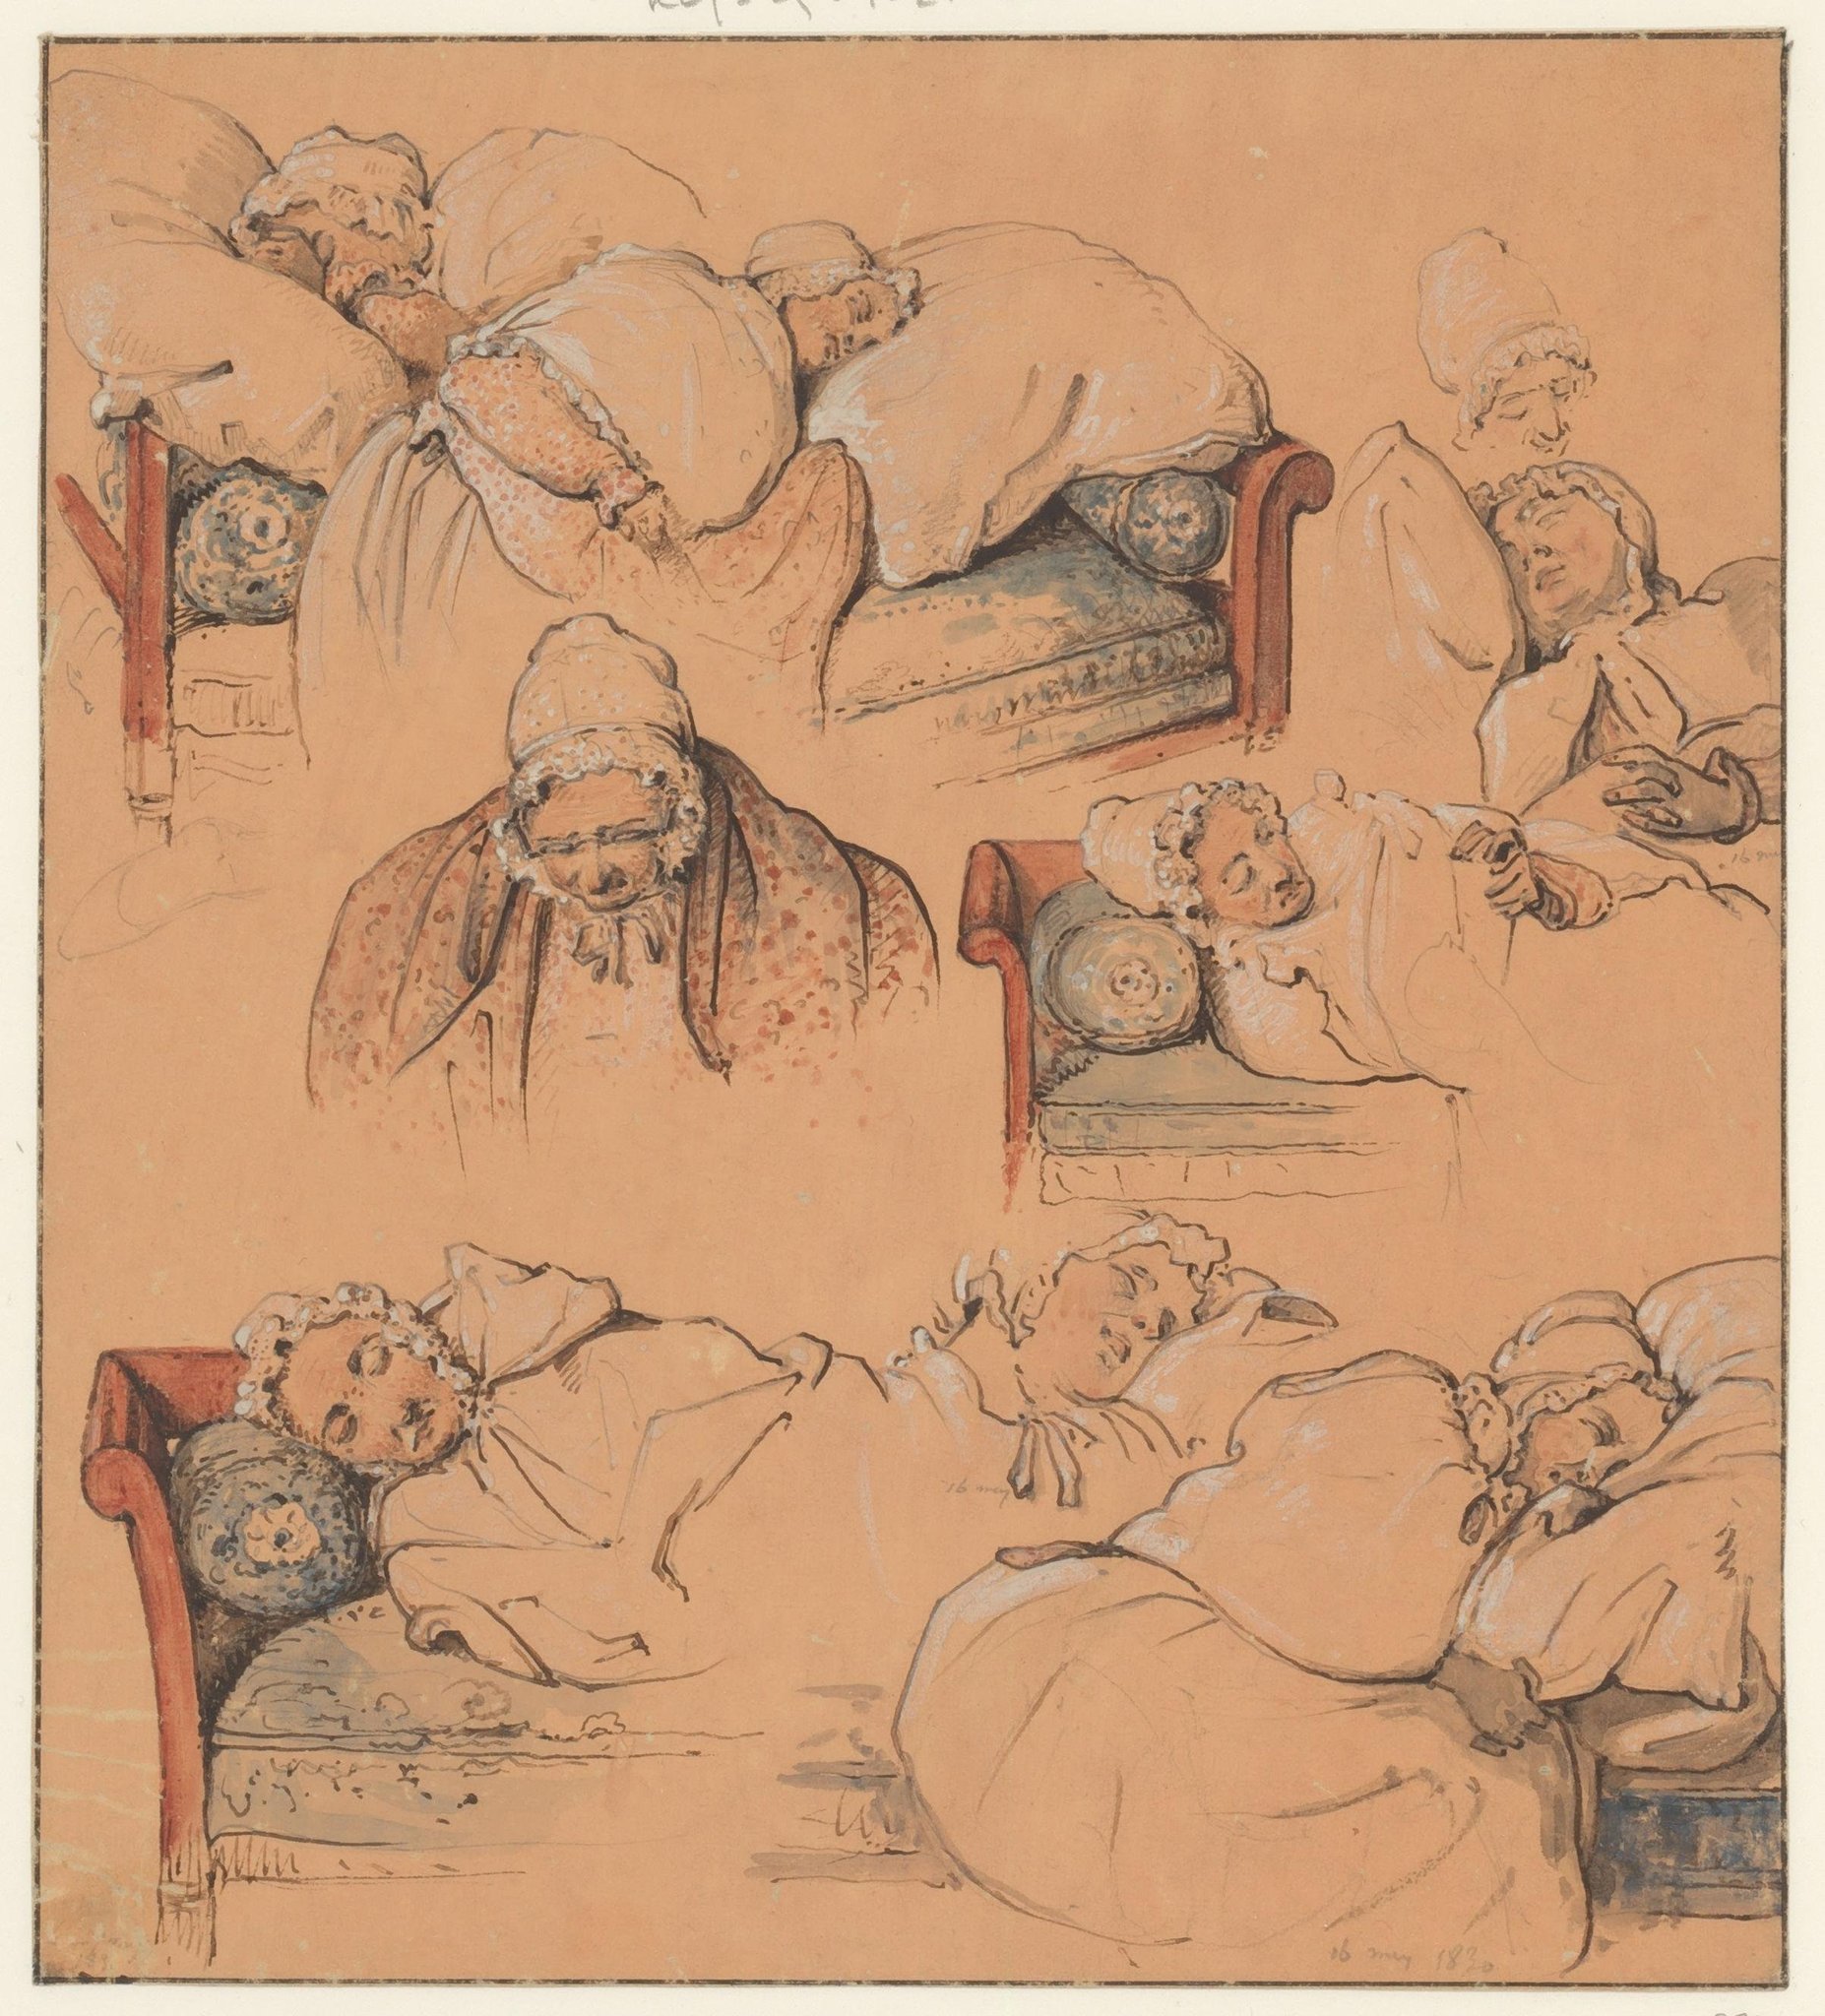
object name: drawing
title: Schetsblad met slapende vrouwen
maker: christiaan andriessen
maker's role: draughtsman, print maker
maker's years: 1775-1846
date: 1785-1846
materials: paint, ink, paper, watercolor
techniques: brush, pen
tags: adult woman, old woman, sleeping; unconsciousness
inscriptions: stamp, collector's mark: Lugt 1641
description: Schetsblad met negen slapende vrouwen. Onderwerpsrubrieken binnen de Atlas Zeden en Gewoonten: Zeden en Gewoonten in Engeren Zin, De Kleeding, Kleederdrachten (tijdvakken), Het begin der 19de eeuw. Teekeningen van Christiaan Andriessen, † 1819. mannen en vrouwen. stadstypen.